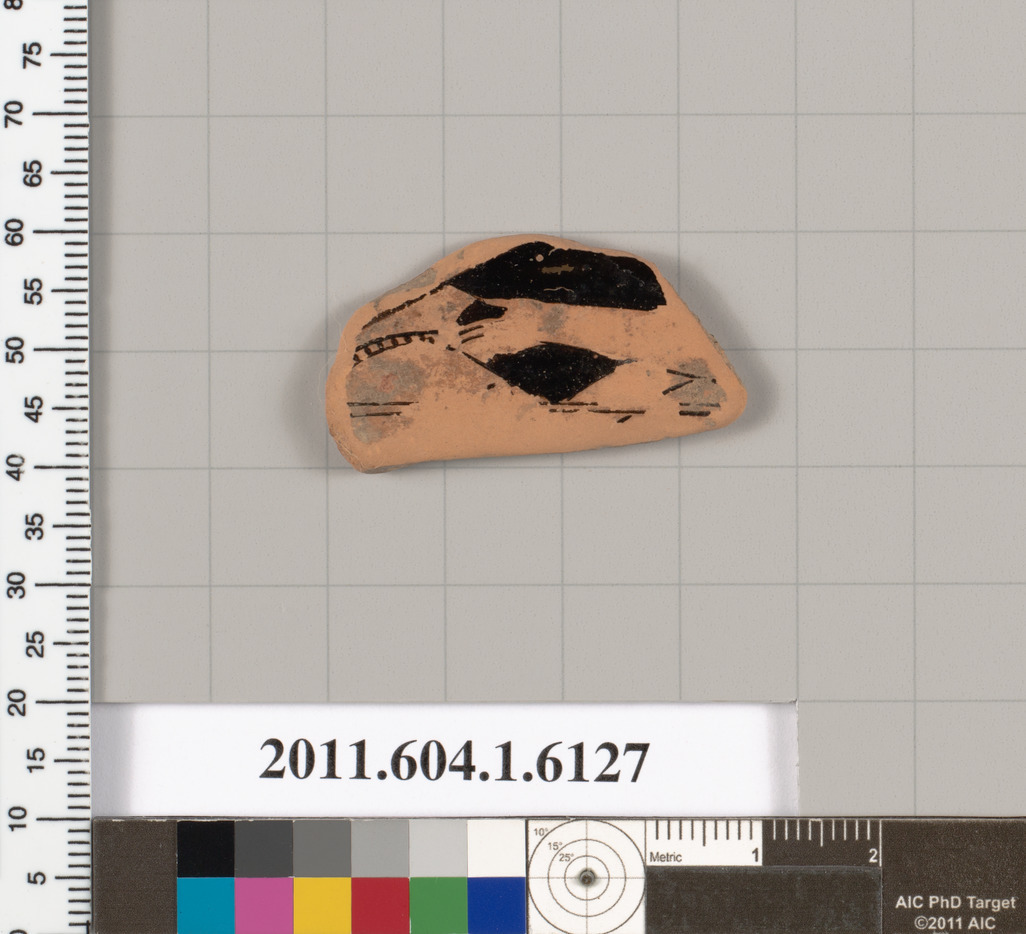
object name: kylix fragment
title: Terracotta rim fragment of a kylix (drinking cup)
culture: greek, attic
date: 520-500 BCE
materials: terracotta